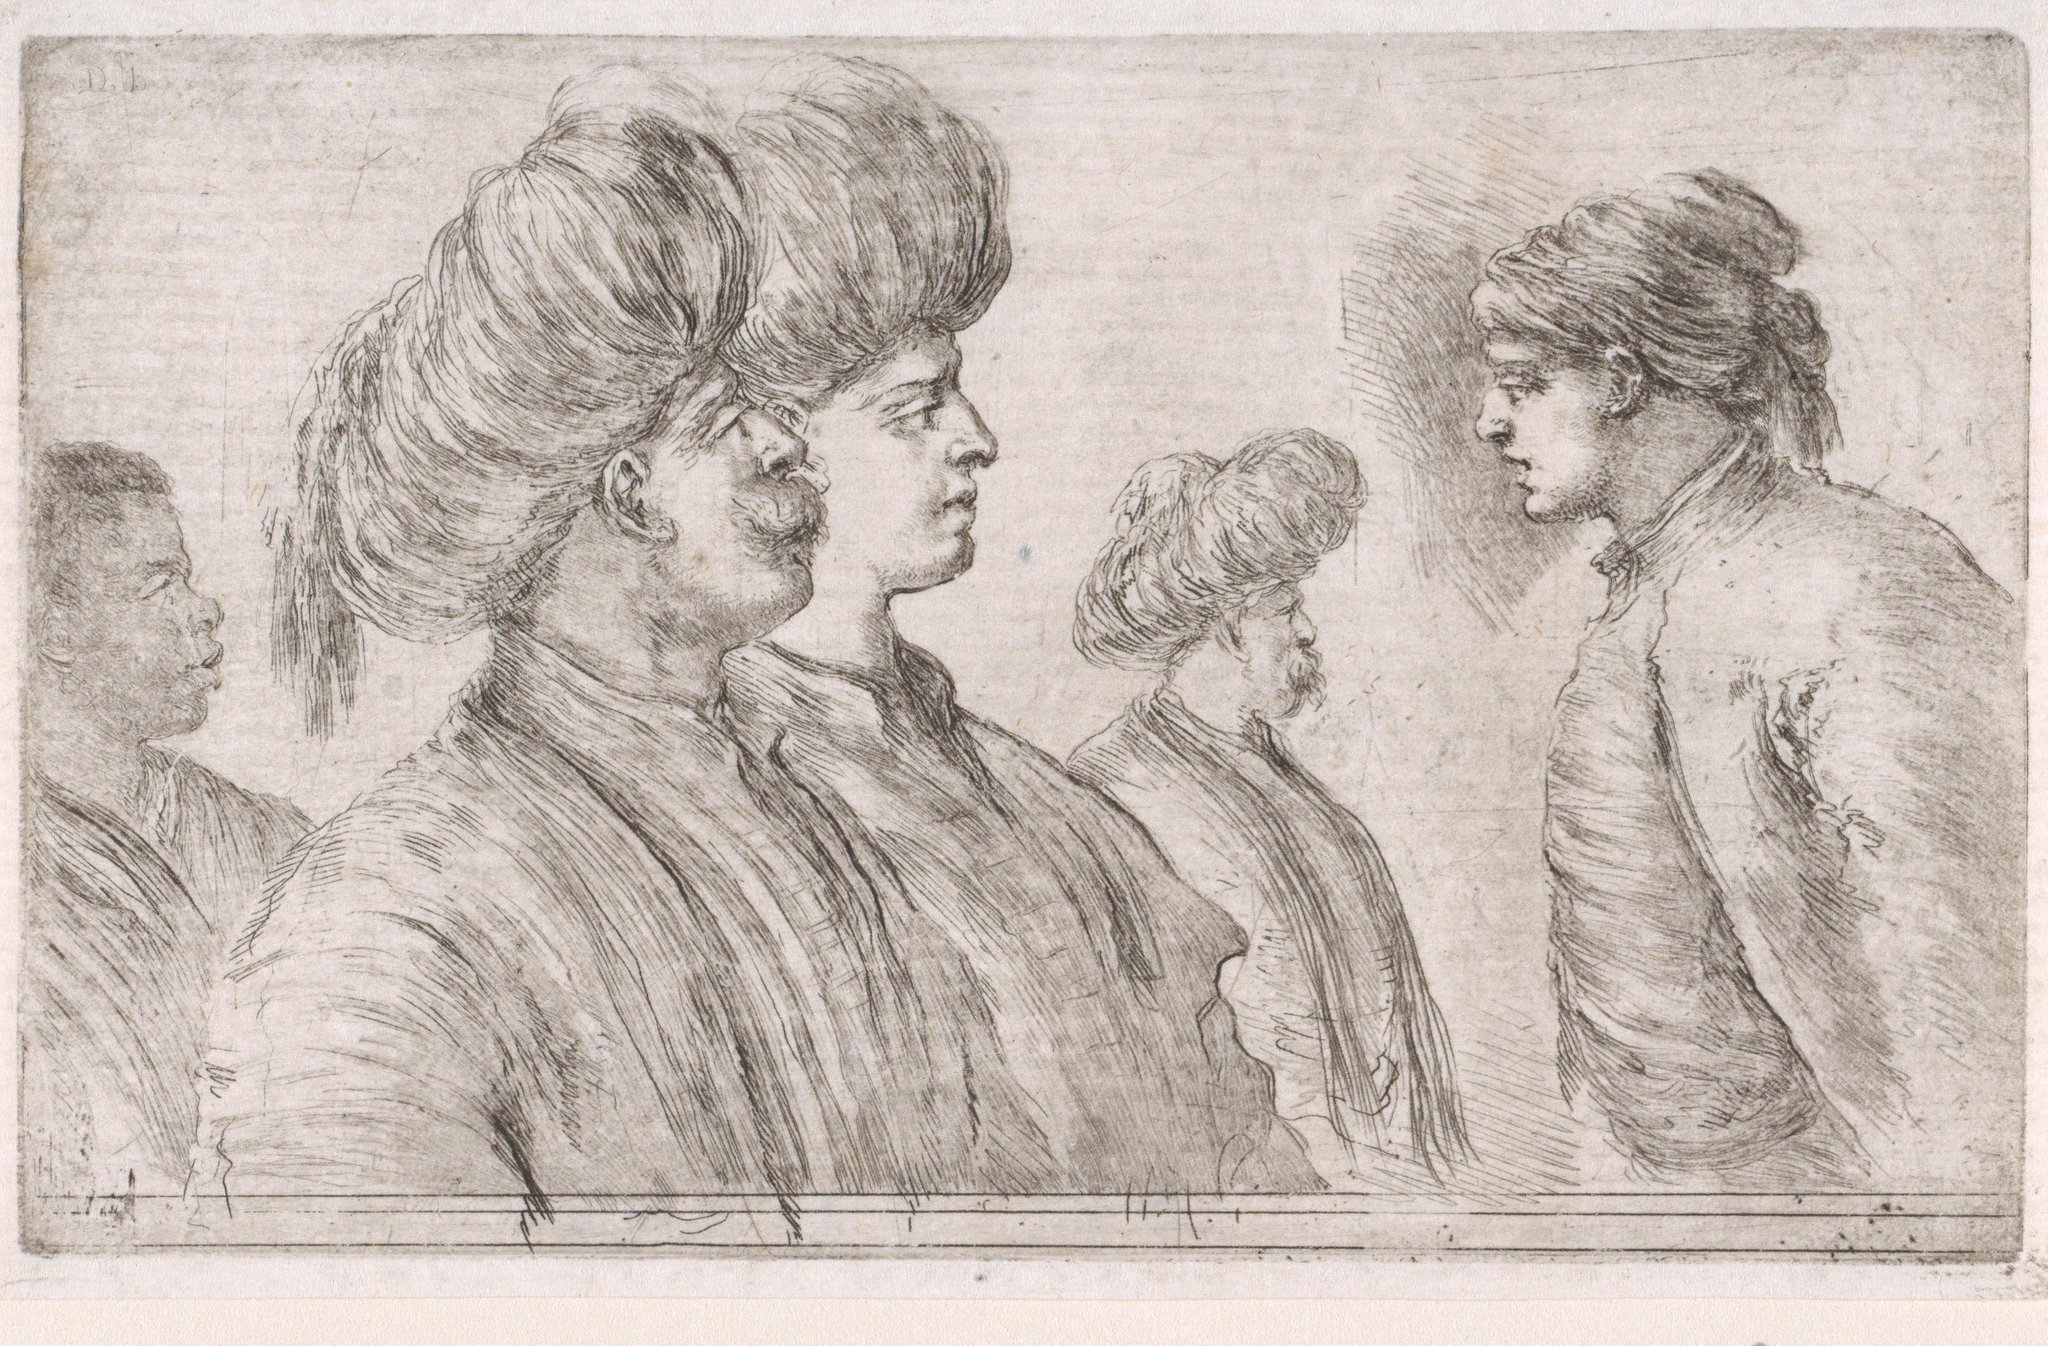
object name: print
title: Vier Turkse mannen met tulbanden en een Afrikaanse man in profiel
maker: stefano della bella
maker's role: draughtsman, print maker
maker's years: 1610-1664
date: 1620-1664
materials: paper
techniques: etching, intaglio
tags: asiatic races and peoples: turks, africans, head-gear: turban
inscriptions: collector's mark: Lugt 240